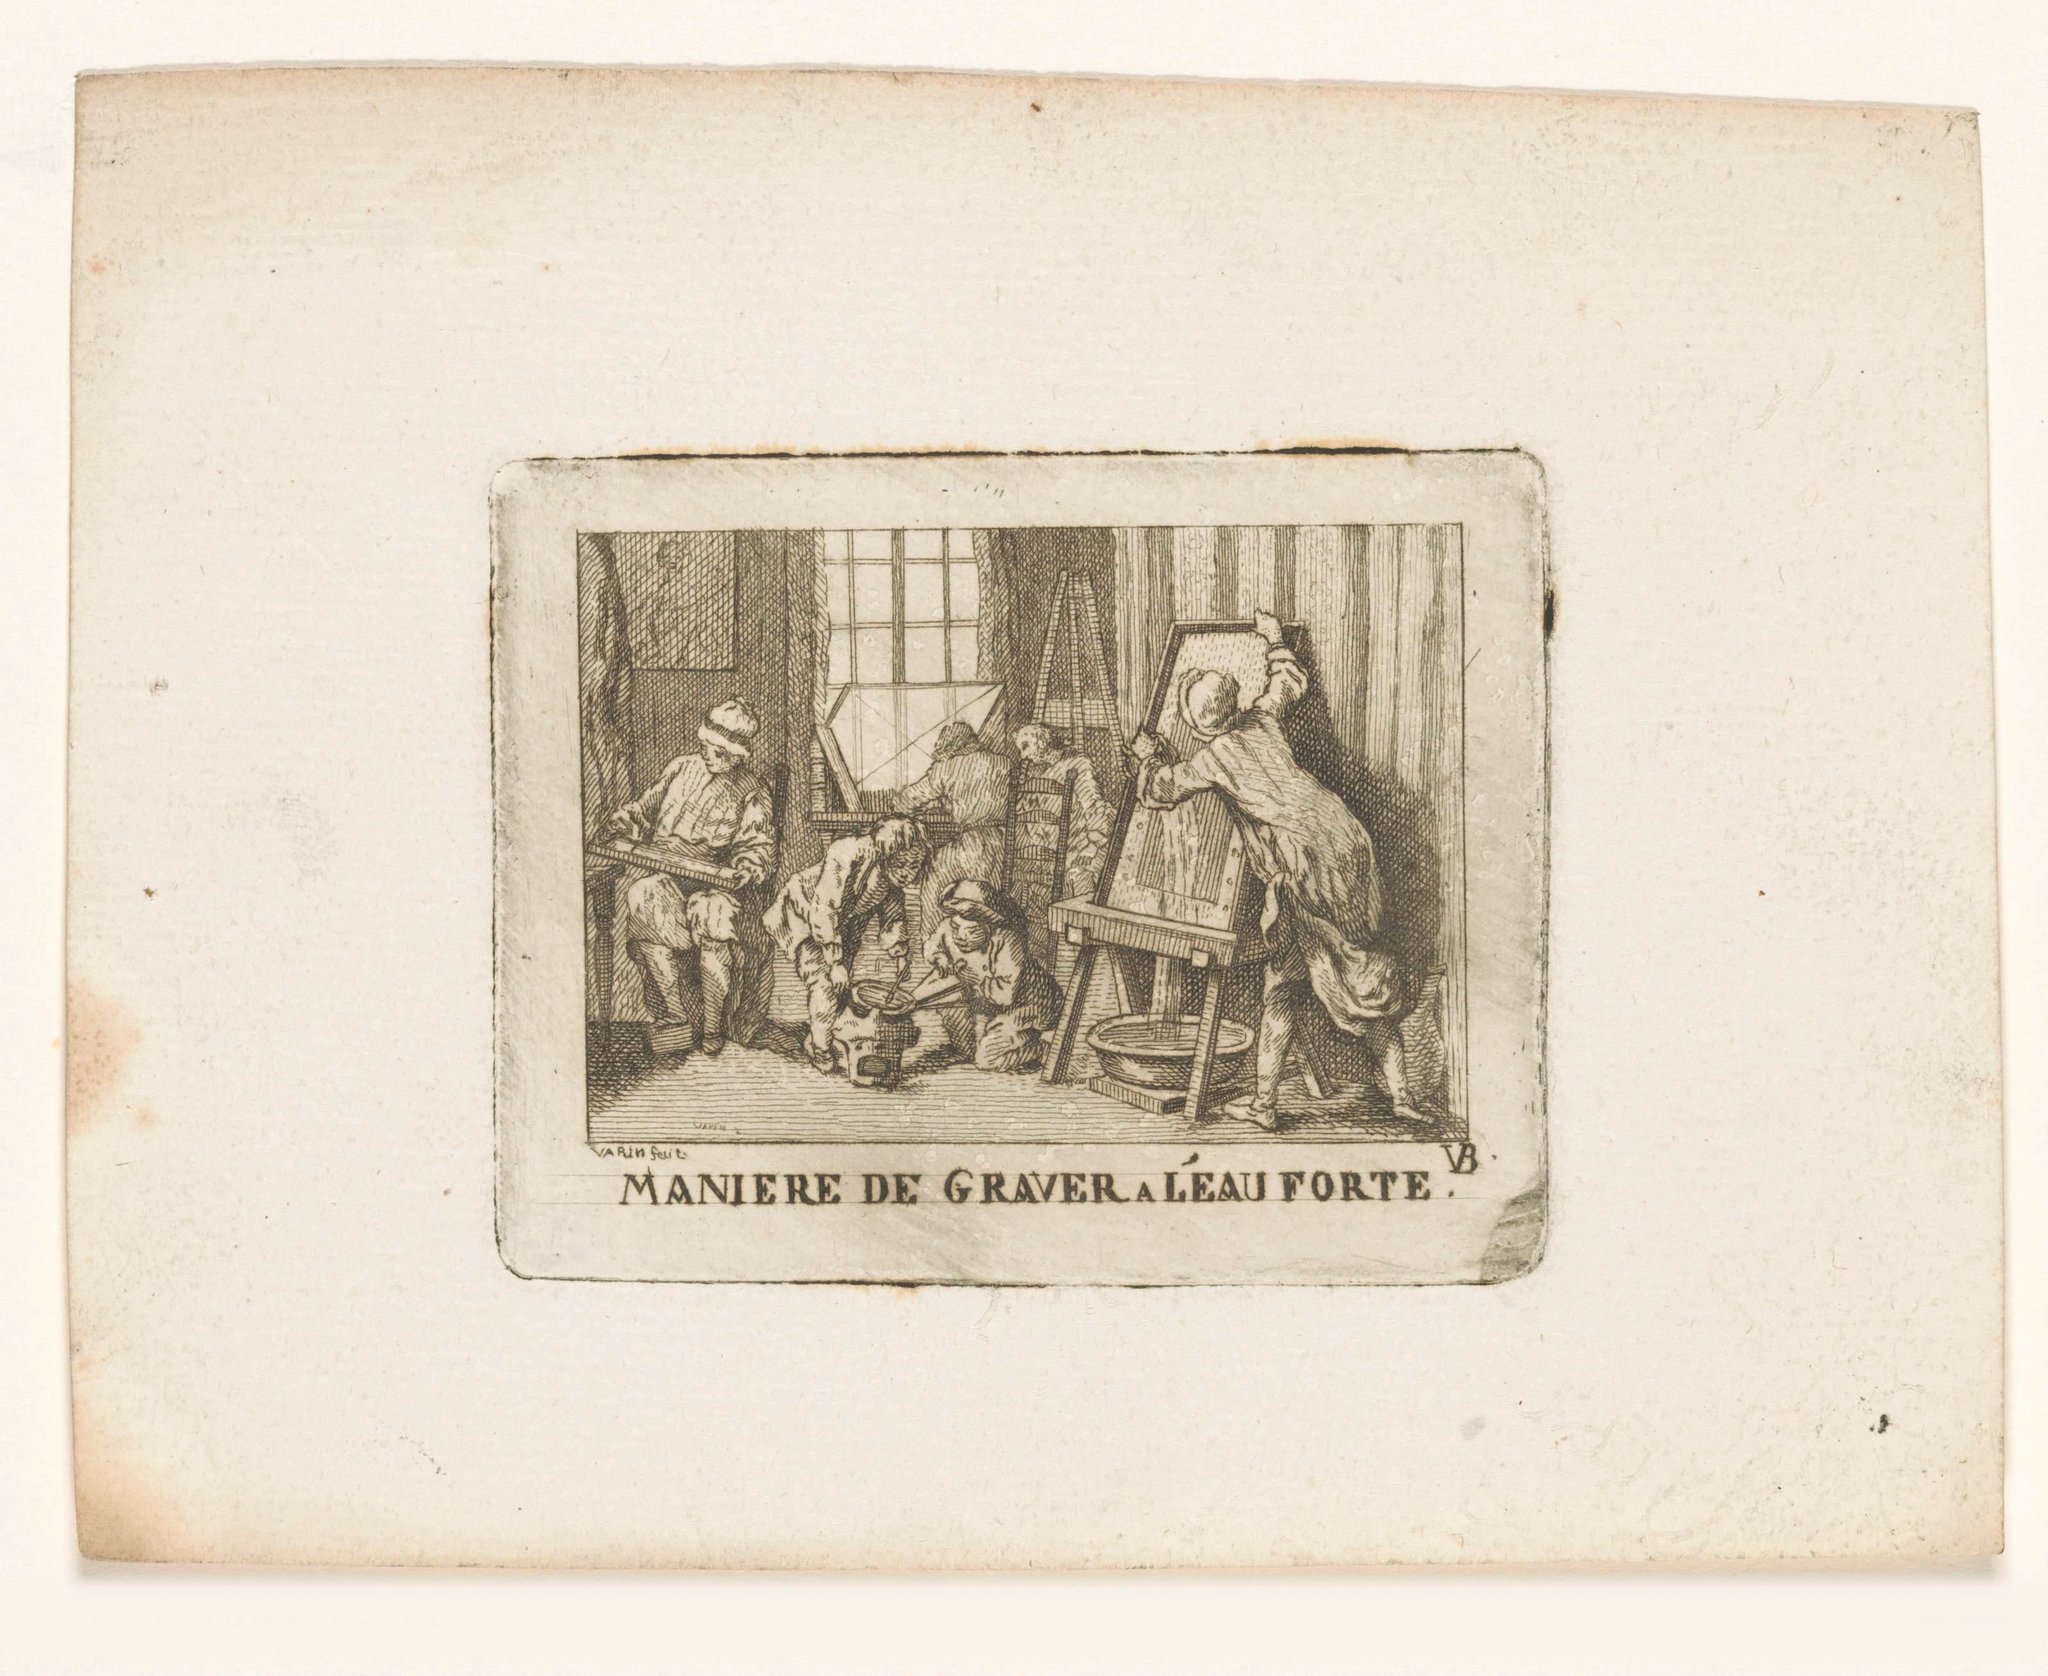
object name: print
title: Atelier van een prentmaker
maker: varin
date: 1745-1850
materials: paper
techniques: etching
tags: engraver, etcher, artist at work, in his workshop (+ graphic arts), tools, implements of graphic artist, workshop, studio of the artist (in general)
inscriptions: collector's mark: Lugt 4779, collector's mark: Lugt 2228, collector's mark: Lugt 4780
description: Kopie in spiegelbeeld naar een illustratie gebruikt in: Bosse, Abraham. De la maniere de graver a l'eau forte et au burin. Paris: C.A. Jombert, 1745.